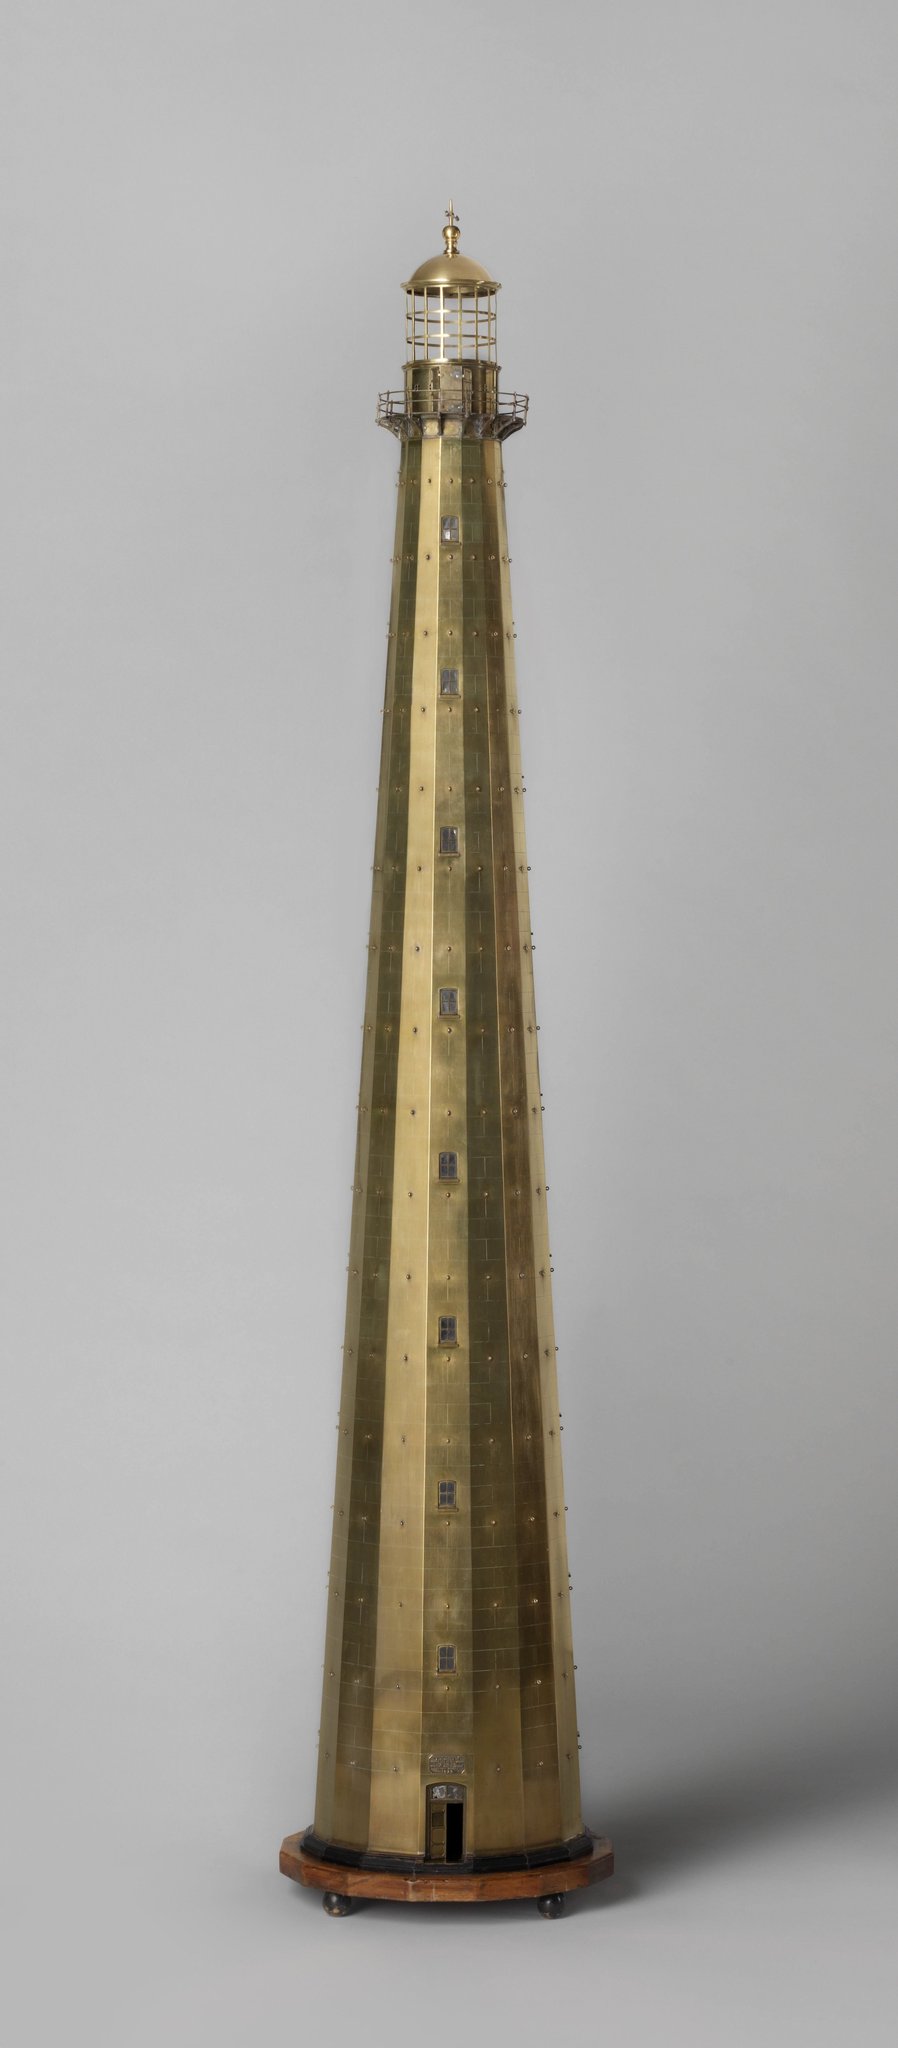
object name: presentation model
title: Model of the Vlakkenhoek lighthouse on Sumatra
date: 1879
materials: brass, wood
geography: the hague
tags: lighthouse, lightship, sumatra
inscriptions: inscription, on the back: ‘L.I. Enthoven & Co / ’s GRAVENHAGE / 1879’, inscription, above the door: ‘ONDER DE REGERING VAN / Z.M. WILLEM III/ KONING DER NEDERLANDEN / ENZ: ENZ: ENZ: / OPGERIGT VOOR DRAAILICHT / EERSTE GROOTE / 1879 P. LEEMANS’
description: The full-scale, 60-metre-high version of this lighthouse was erected at Vlakkenhoek, on the southwest point of Sumatra. The tower was built in The Hague by Enthoven & Co., then shipped to Sumatra. The strength of the cast-iron structure was proven during the 1883 volcano eruption of Krakatoa; only the lighthouse withstood the tsunami that devastated everything else.